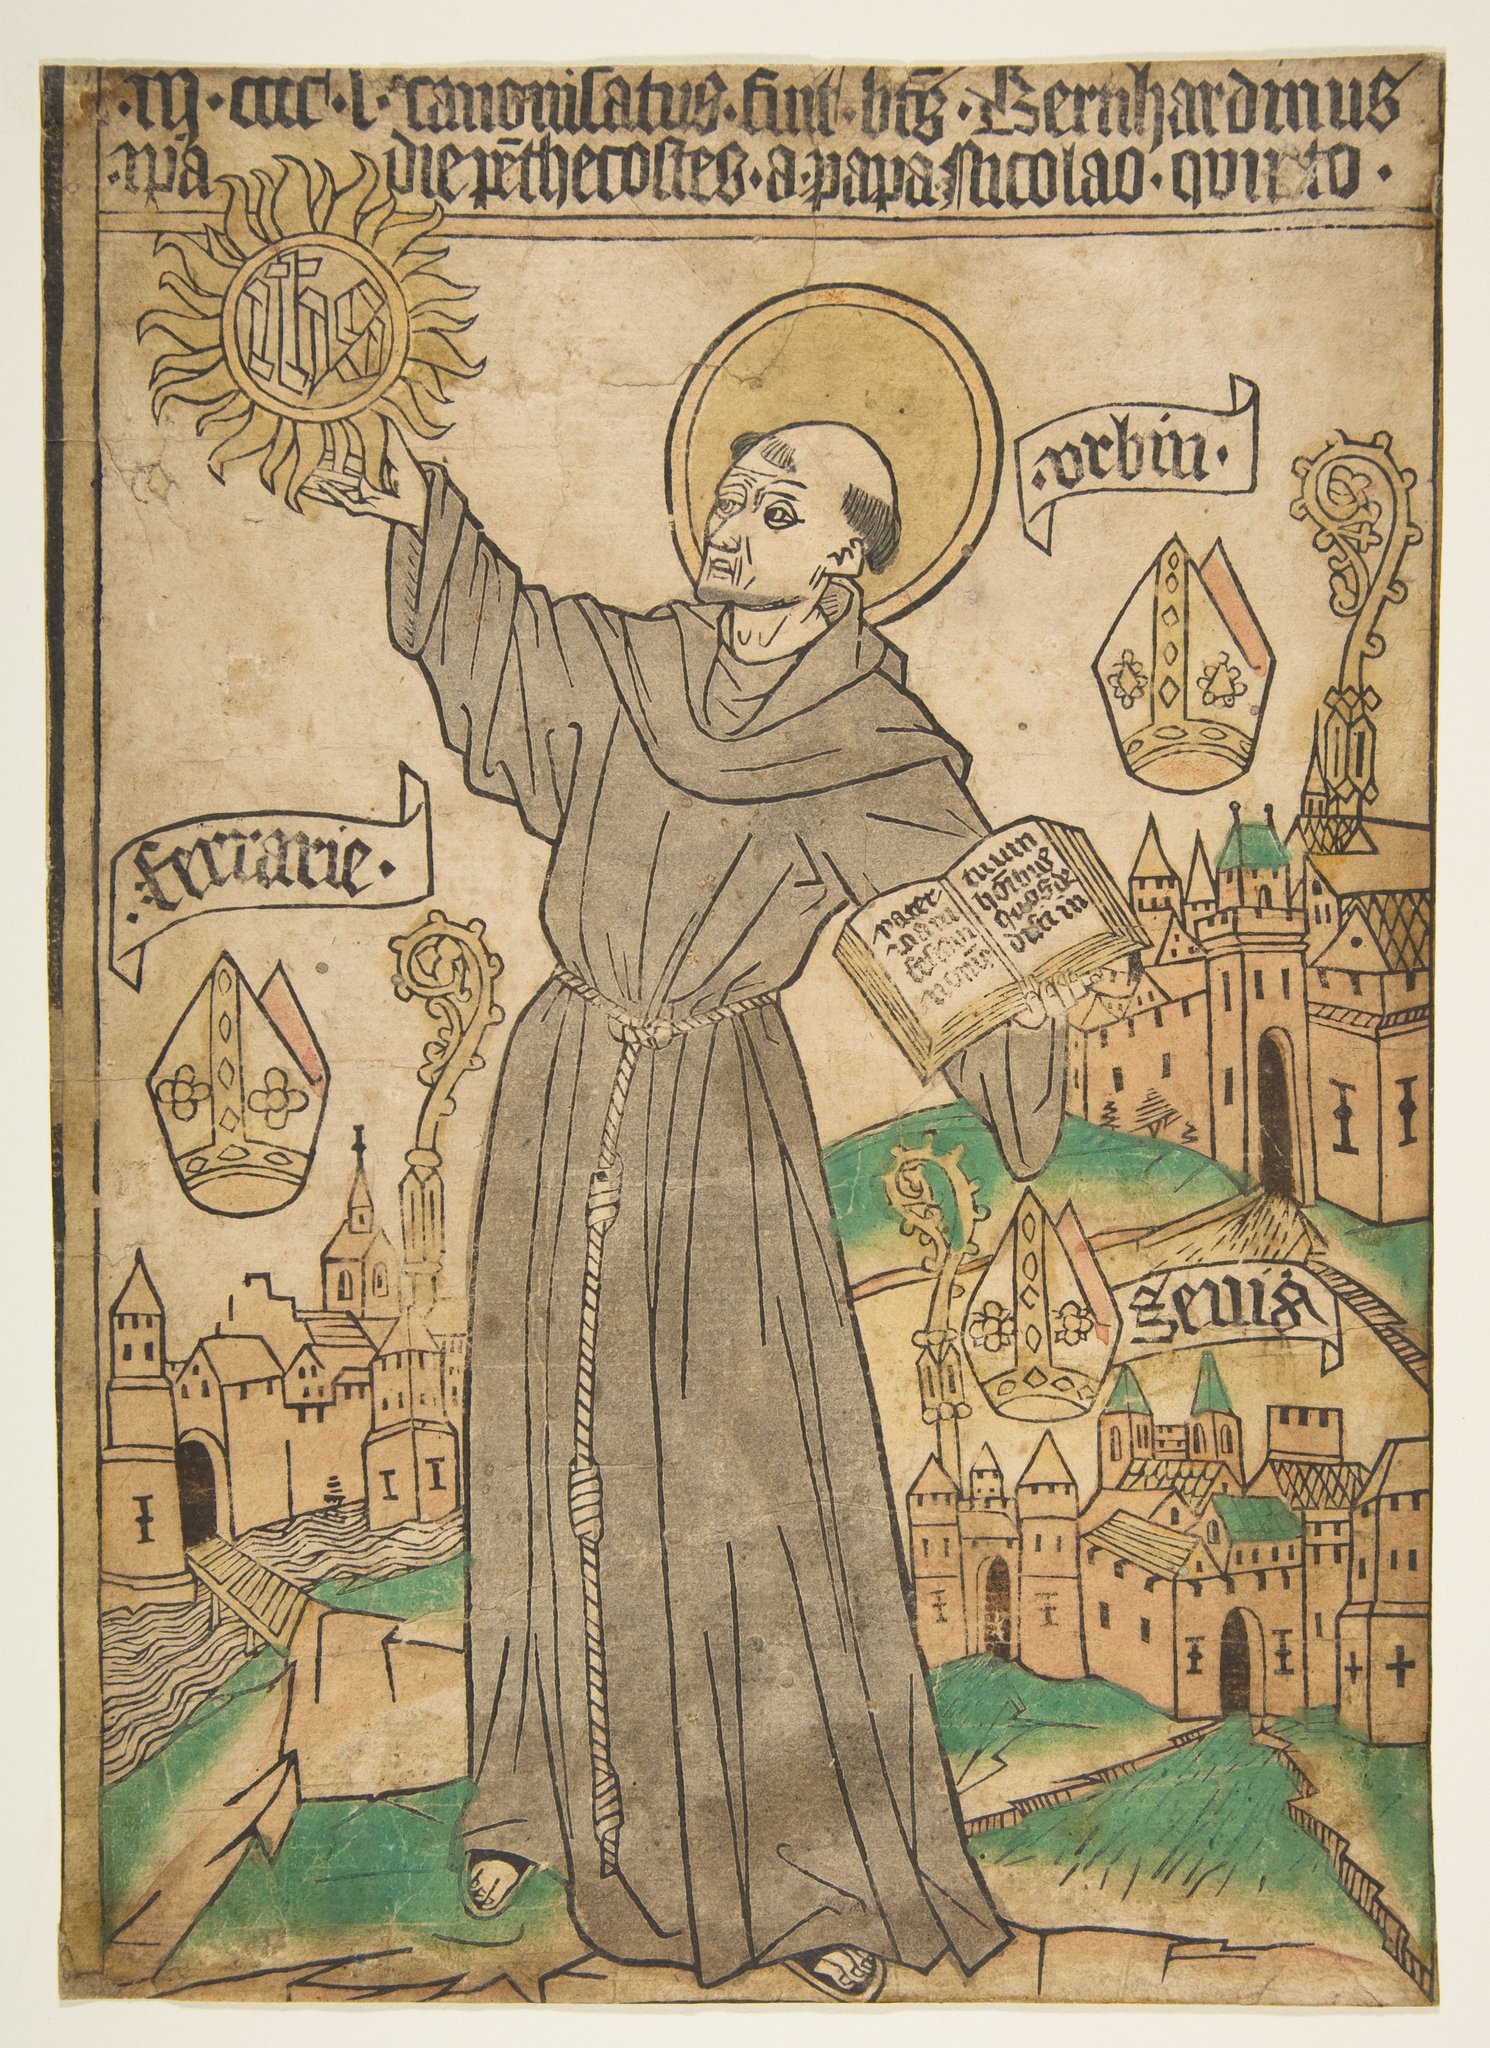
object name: print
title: Saint Bernardino of Siena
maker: anonymous, german, upper germany, 15th century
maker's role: artist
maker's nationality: german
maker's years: 1400-1500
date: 1465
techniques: hand coloring, woodcut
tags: books,croziers,saints